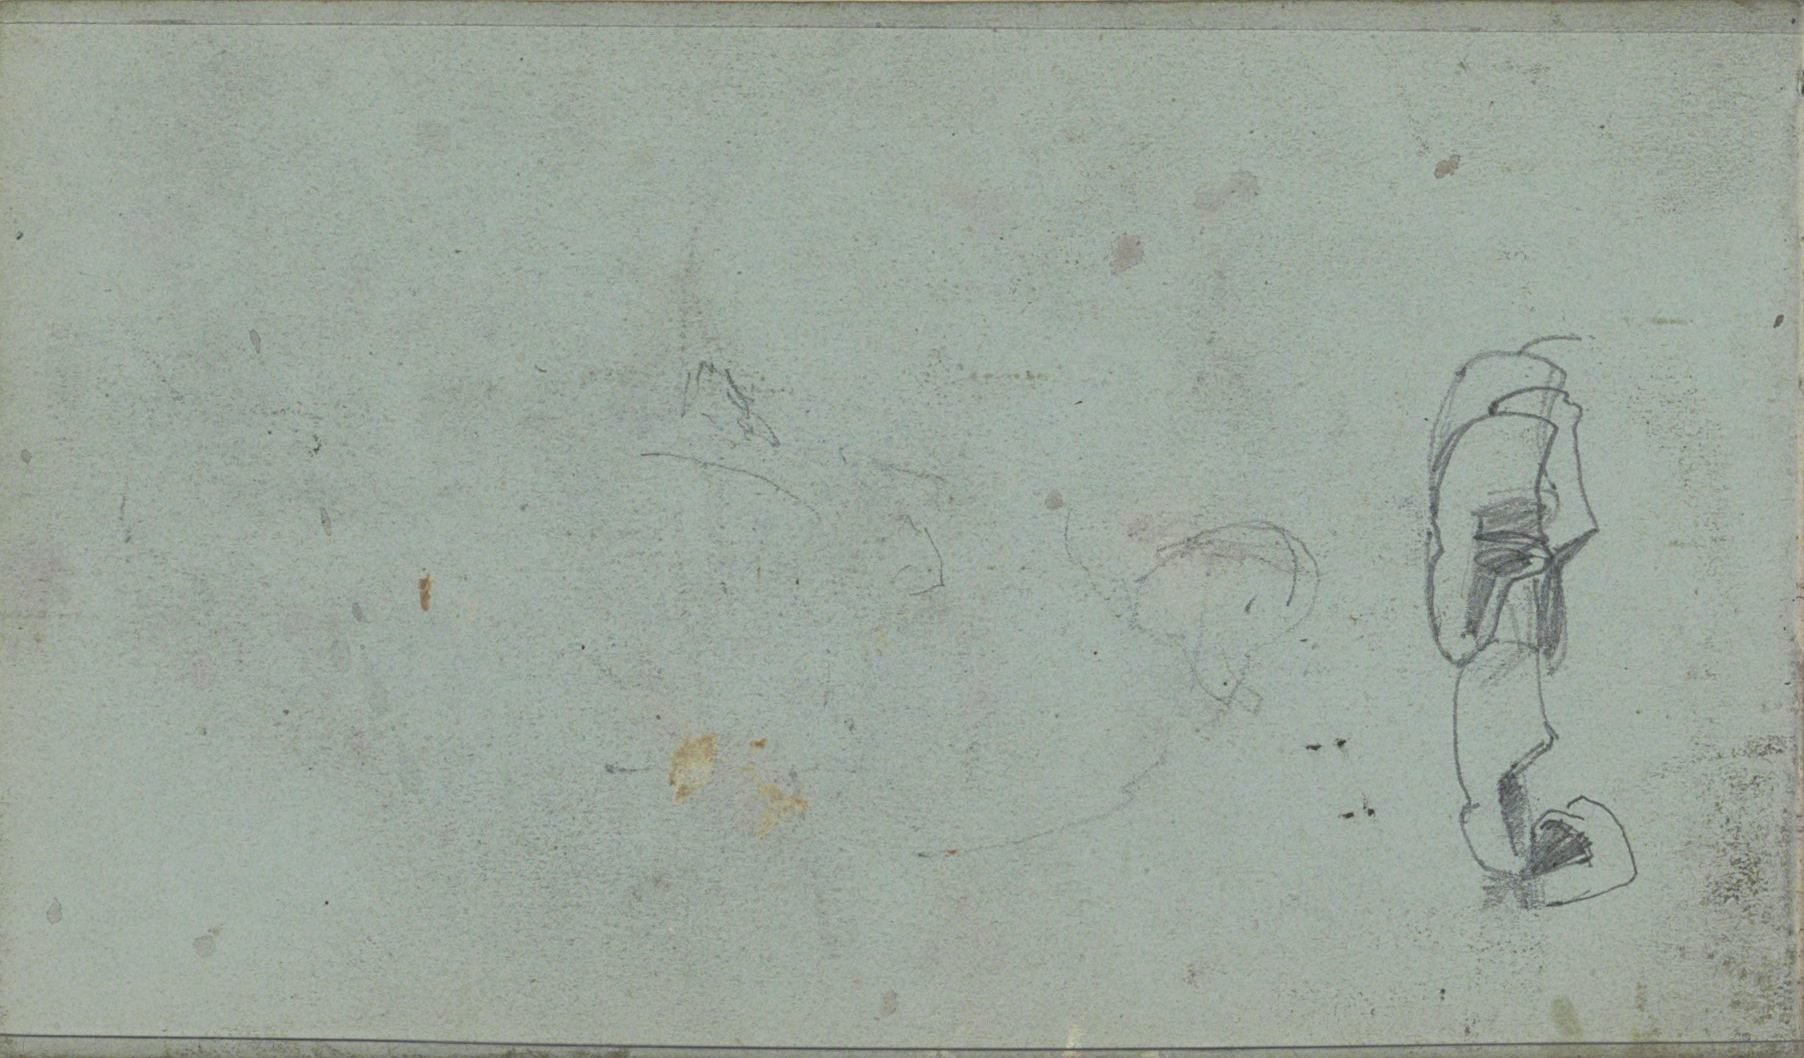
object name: sketchbook leaf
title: Klompen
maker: george clausen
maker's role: draughtsman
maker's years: 1852-1912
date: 1875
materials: paper, pencil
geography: volendam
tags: wooden shoes, clogs, folk costume, regional costume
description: Tevens een vrouw met een traditionele muts op het hoofd. Blad 31 verso uit een schetsboek met 46 bladen.